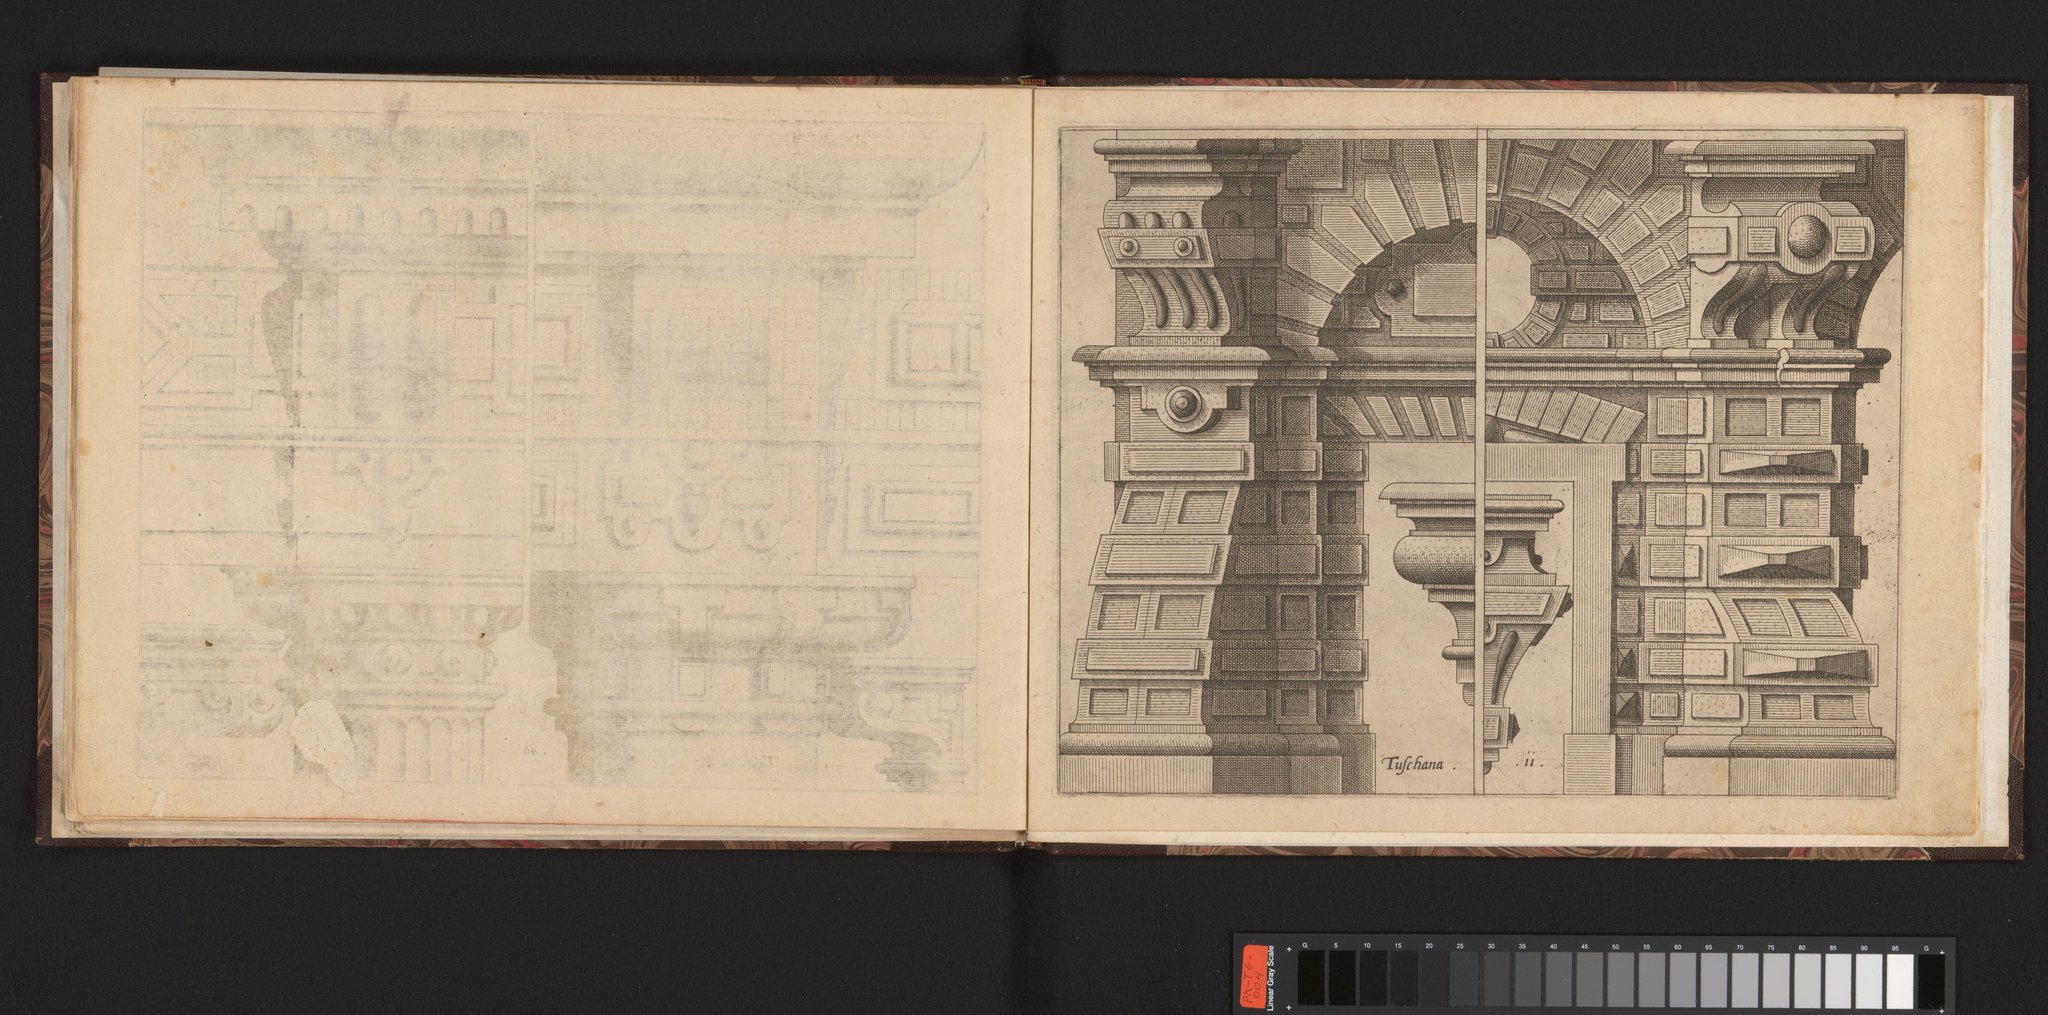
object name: album leaf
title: Architectura de Oorden Tusschana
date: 1578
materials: paper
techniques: etching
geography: antwerp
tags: tuscan order ~ architecture, other architectural details (console), gate, entrance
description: Twee halve portalen in de Toscaanse Orde, geflankeerd door een zuil. De zuilen zijn gedecoreerd met gestileerde bossage, in het linker ontwerp met halve kogels en in het rechter met diamantkoppen. Links en rechts twee consoles. De prent maakt deel uit van een album.